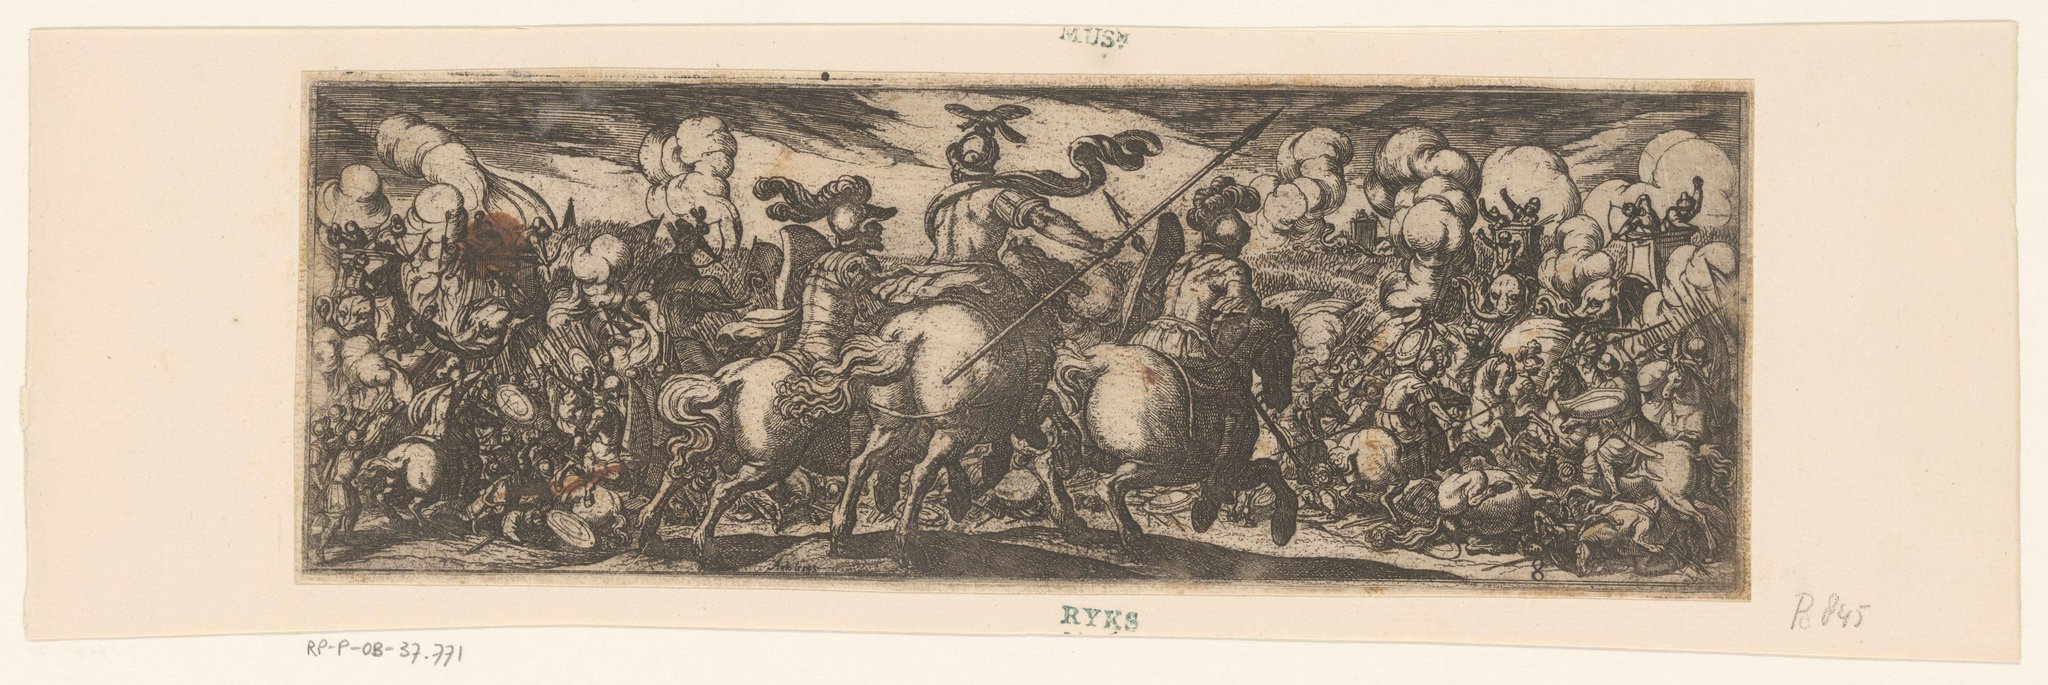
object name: print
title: Gevechtsscènes (serie 2)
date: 1599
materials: paper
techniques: etching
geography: italy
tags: battle, warfare; military affairs (+ cavalry, horsemen), the soldier; the soldier's life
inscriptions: collector's mark: Lugt 2165 of 2166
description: Deze prent maakt deel uit van een reeks van 9 prenten (+ titelprent) met gevechtsscènes. Antonio Tempesta maakte ook een eerdere serie met gevechtsscènes van 10 prenten (+titelprent).